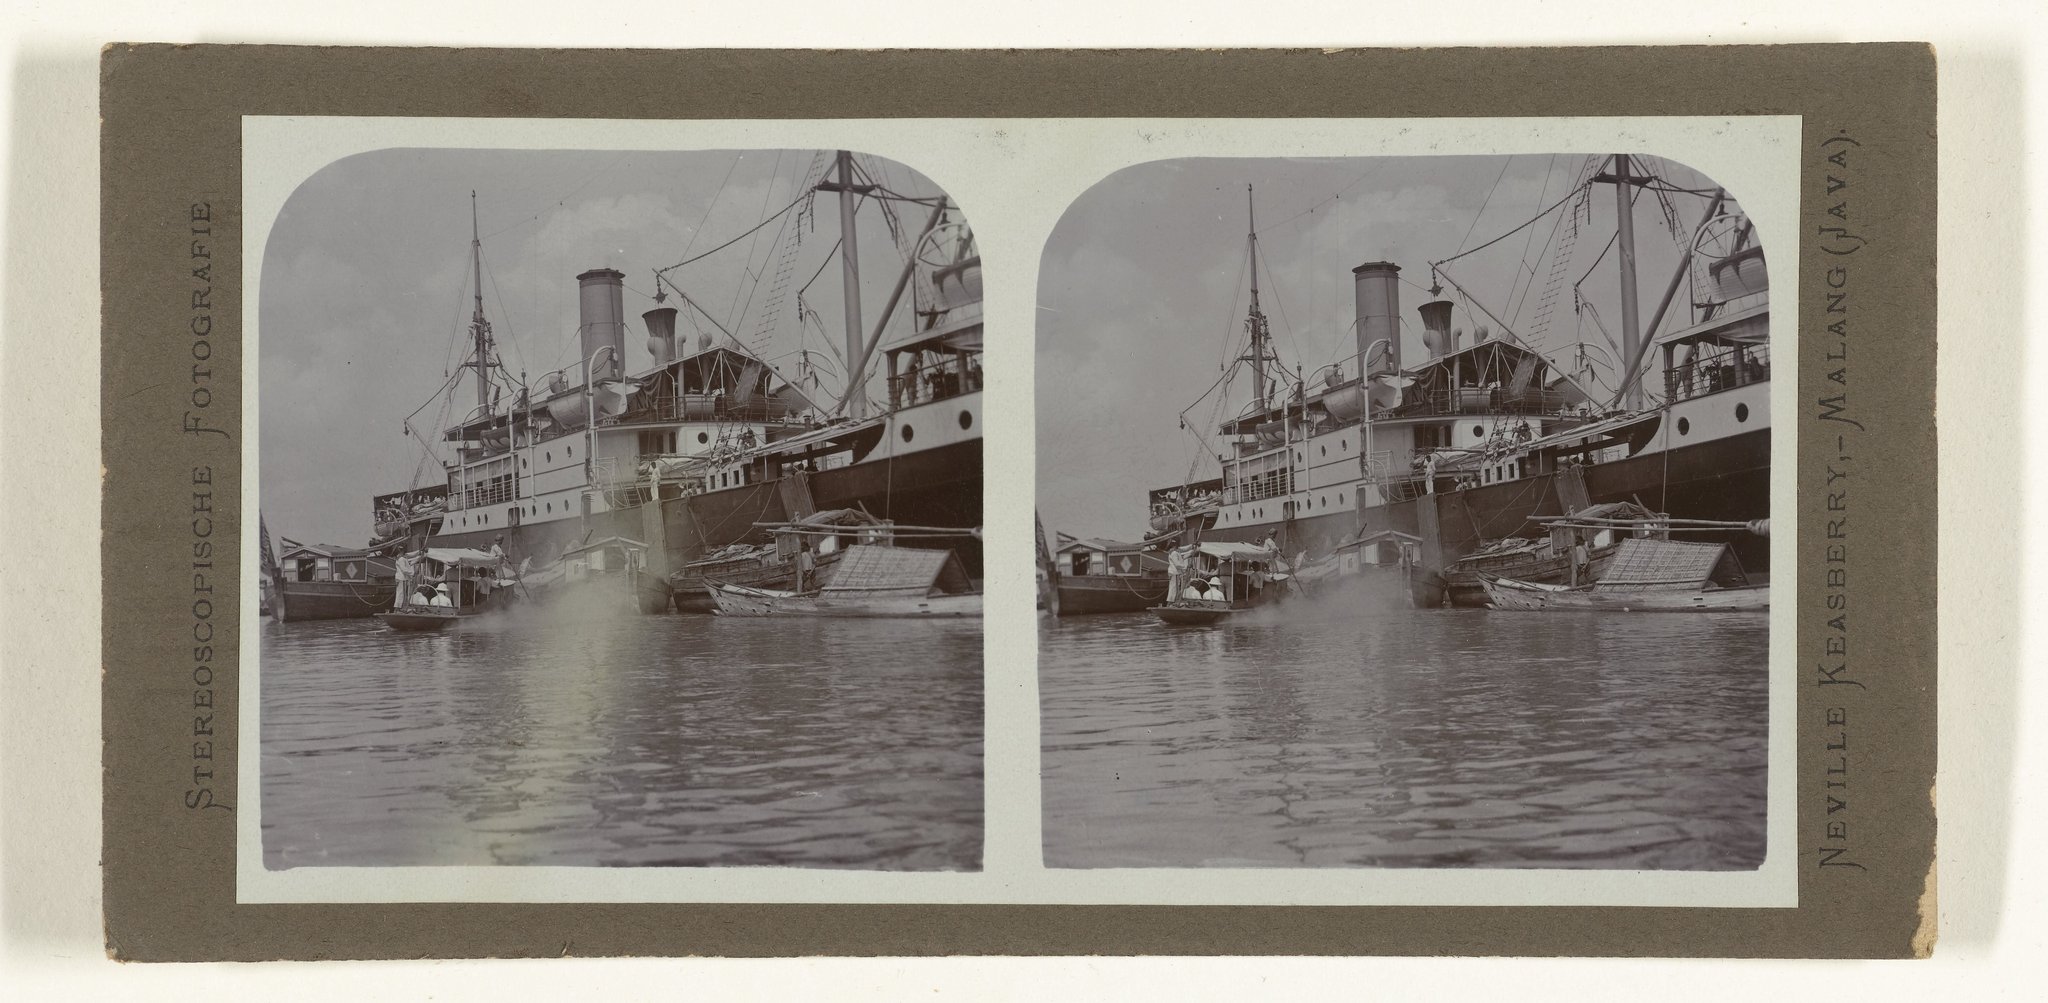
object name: photograph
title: S 2 No 13. Soerabaja op de Reede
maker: neville keasberry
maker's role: fotograaf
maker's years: 1866-1944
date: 1900-1935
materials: cardboard, paper, photographic support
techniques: albumen print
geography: malang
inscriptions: signature: ‘Neville Keasberry, Malang (Java)’, inscription: ‘Stereoscopische Fotografie’